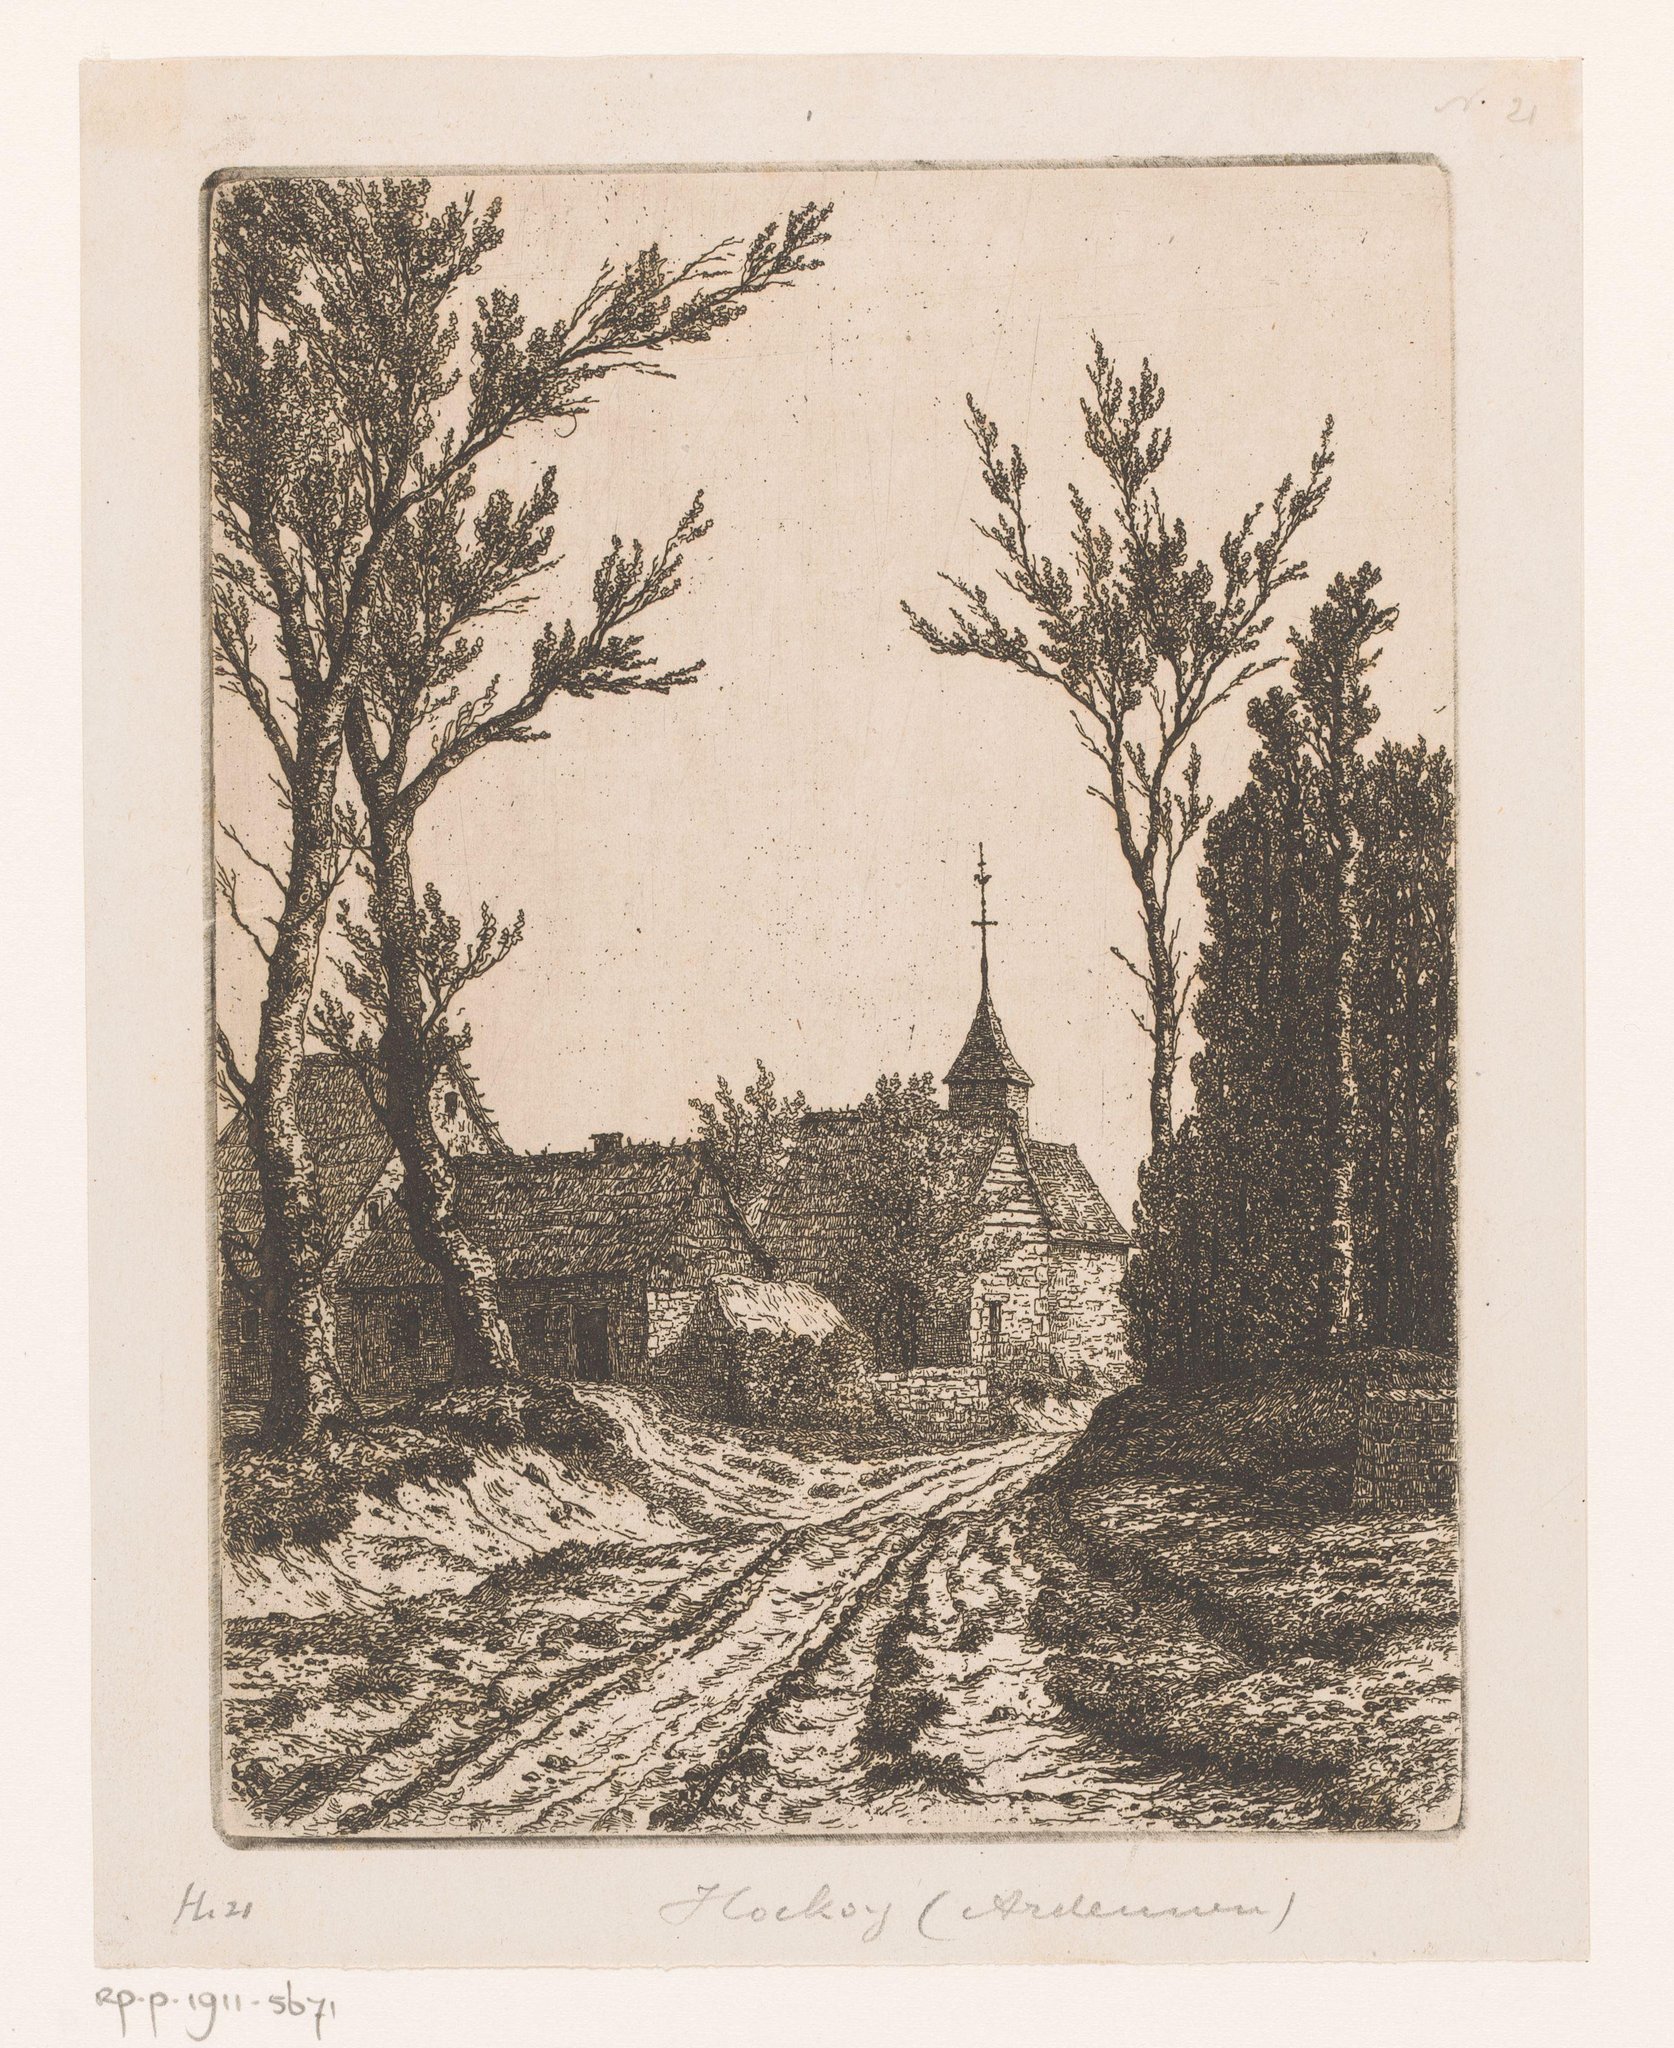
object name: print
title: Gezicht op het dorp Hockai in de Ardennen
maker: jean pierre françois lamorinière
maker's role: print maker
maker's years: 1828-1911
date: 1838-1879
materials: paper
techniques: etching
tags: prospect of village, silhouette of village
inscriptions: collector's mark: Lugt 2228, collector's mark: Lugt 1485